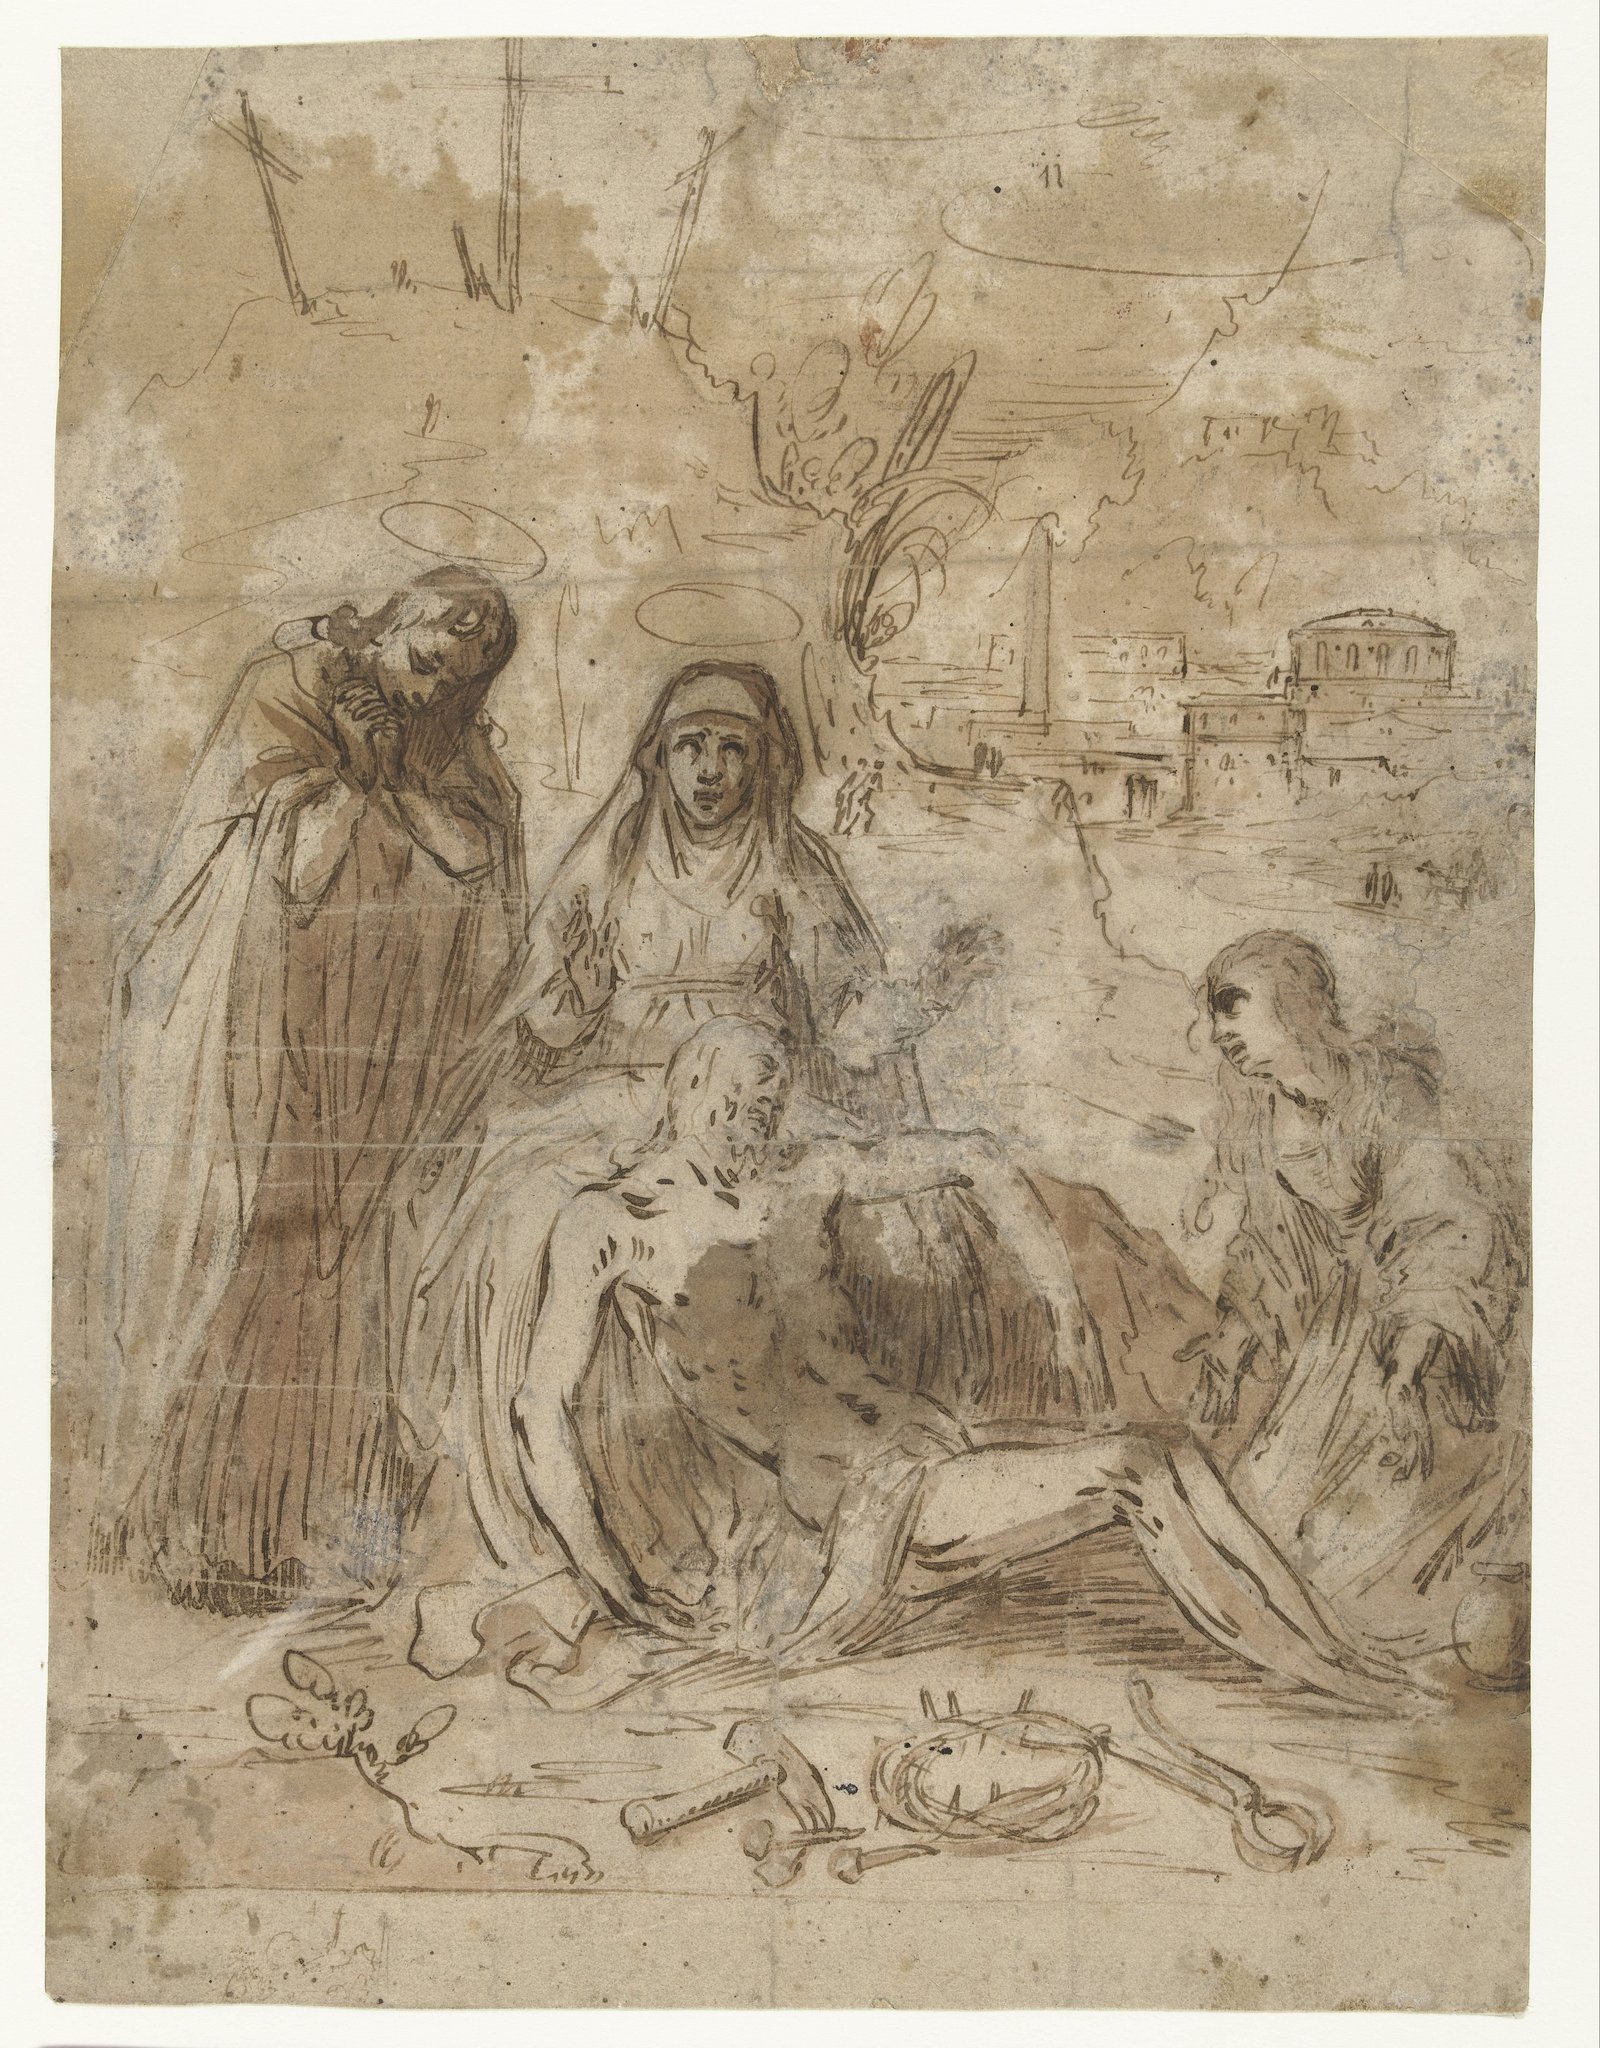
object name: drawing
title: De bewening van Christus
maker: gerard ter borch (i)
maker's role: draughtsman, print maker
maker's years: 1584-1662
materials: chalk, ink, paper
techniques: brush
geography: zwolle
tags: lamentation over the dead christ by his relatives and friends (christ usually without crown of thorns)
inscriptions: inscription: ‘ii’